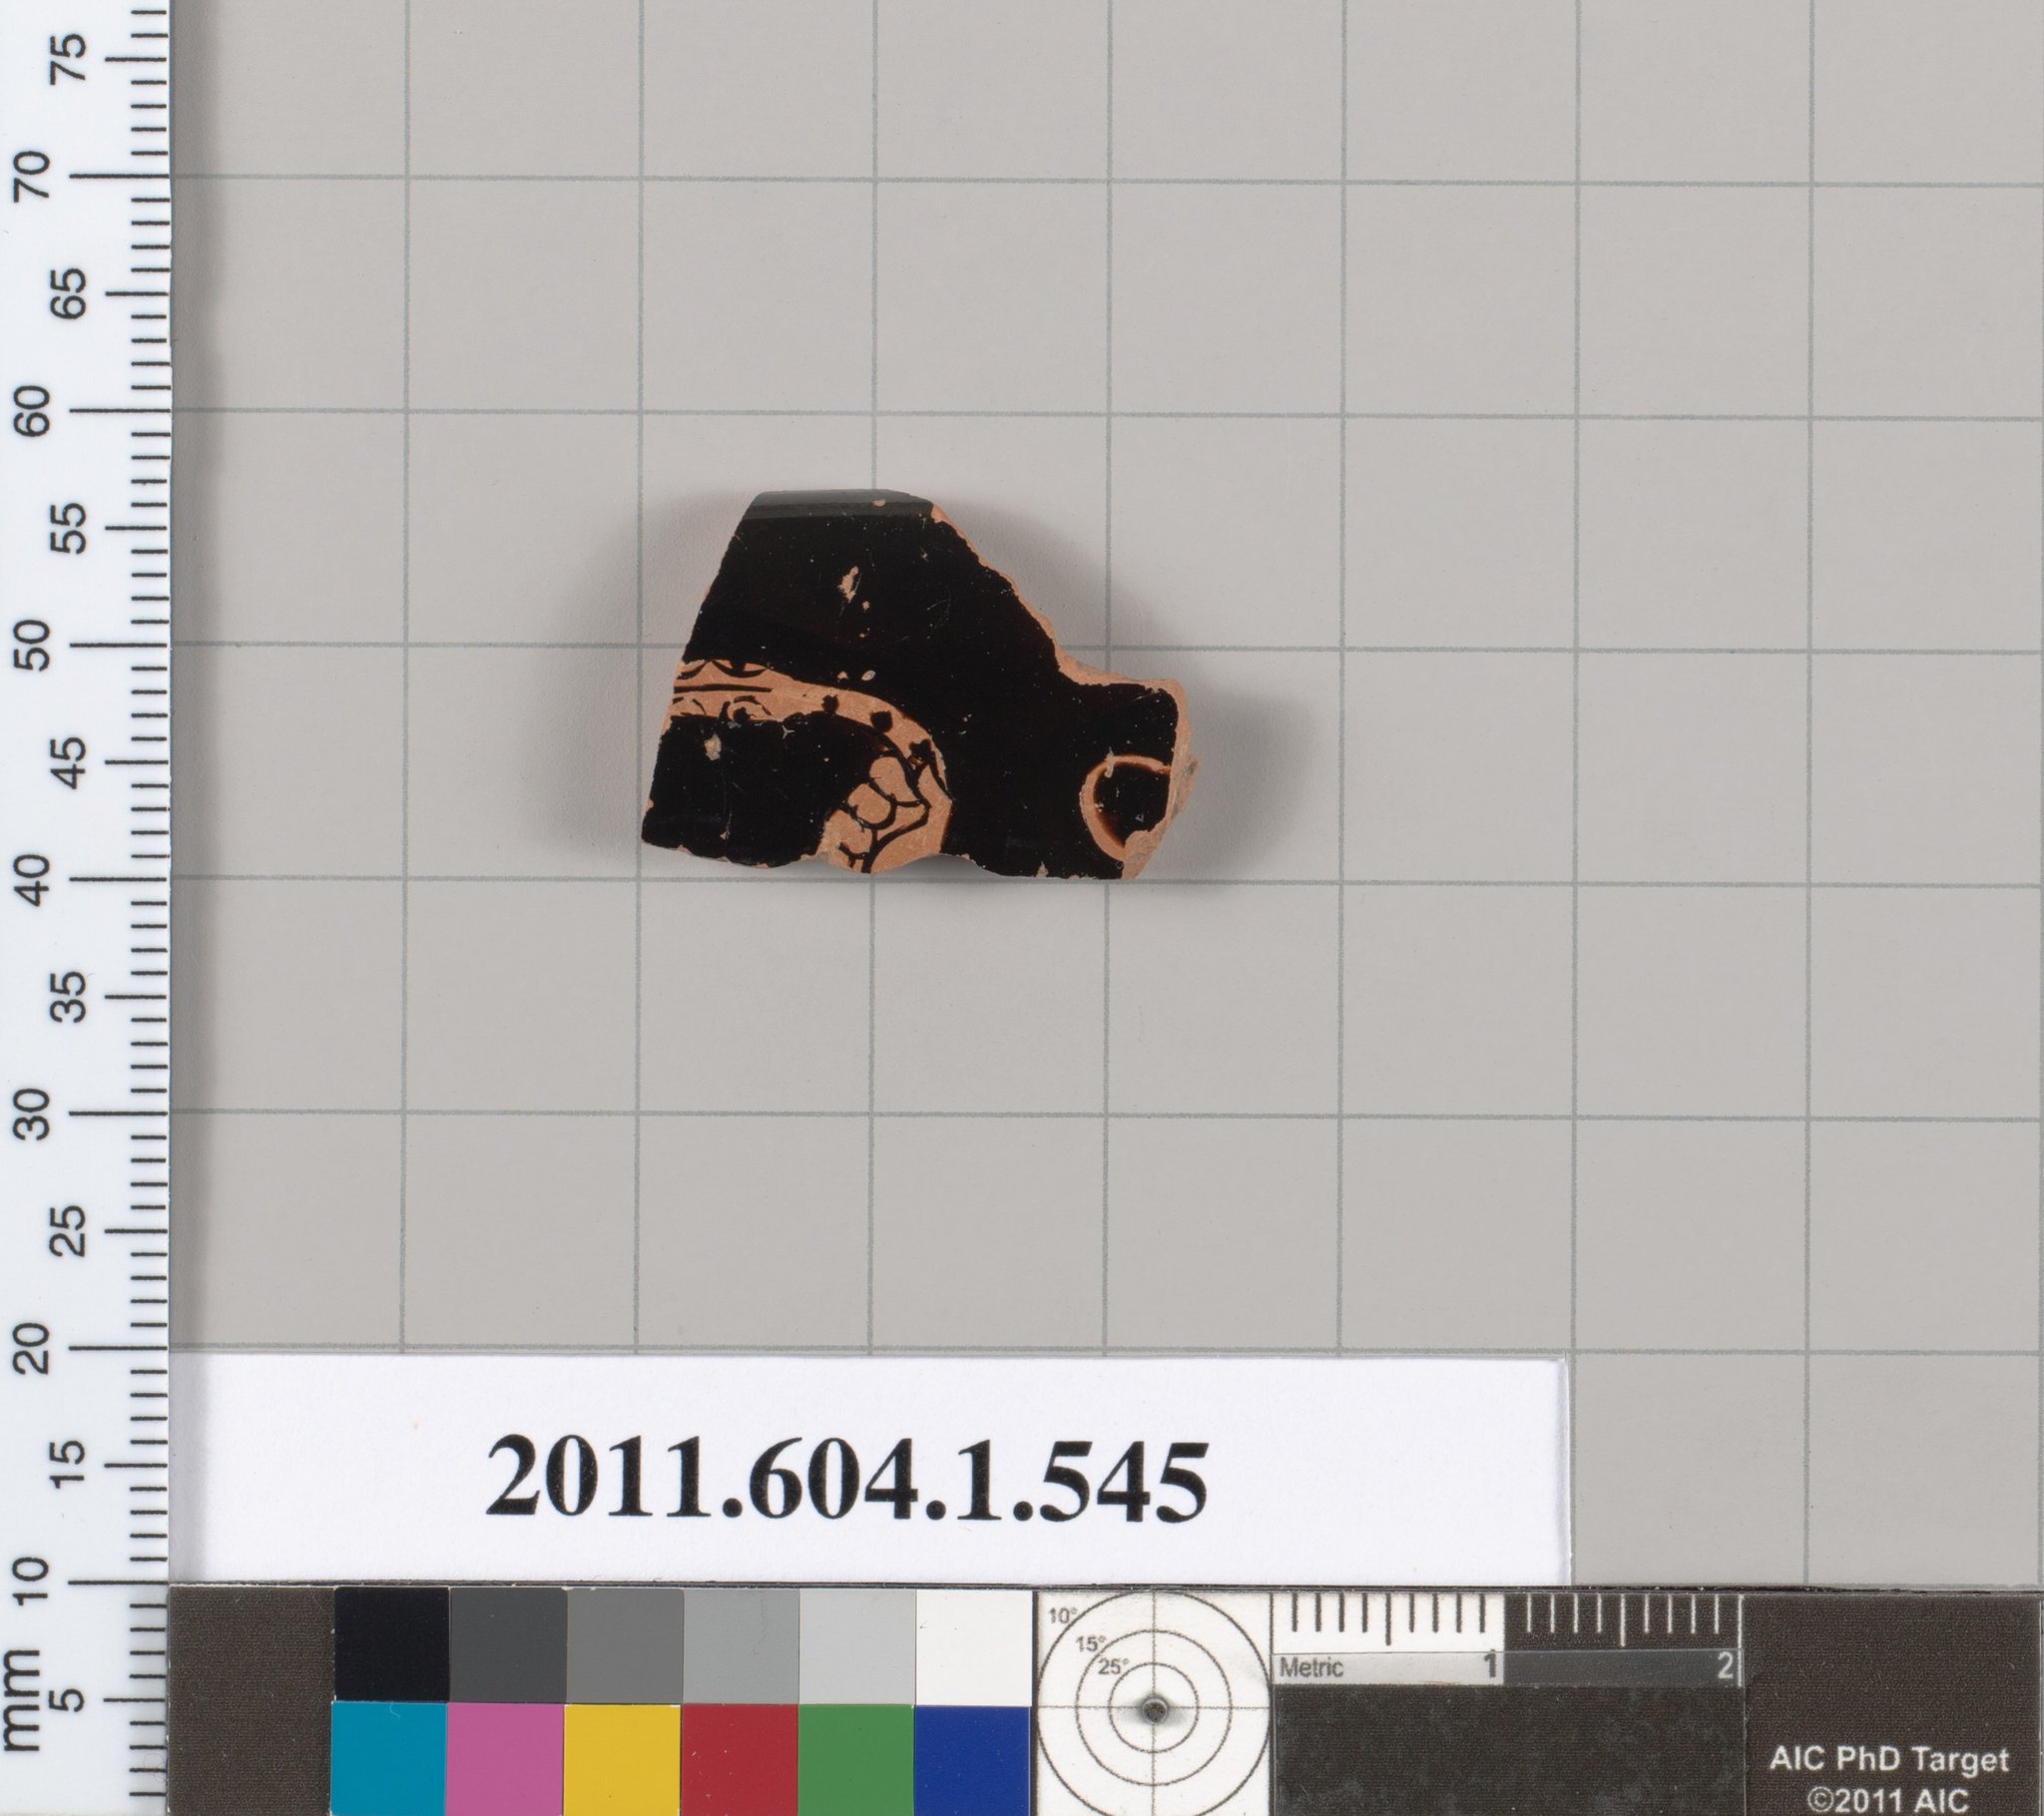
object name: kylix fragment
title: Terracotta rim fragment of a kylix (drinking cup)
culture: greek, attic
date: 480-470 BCE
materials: terracotta